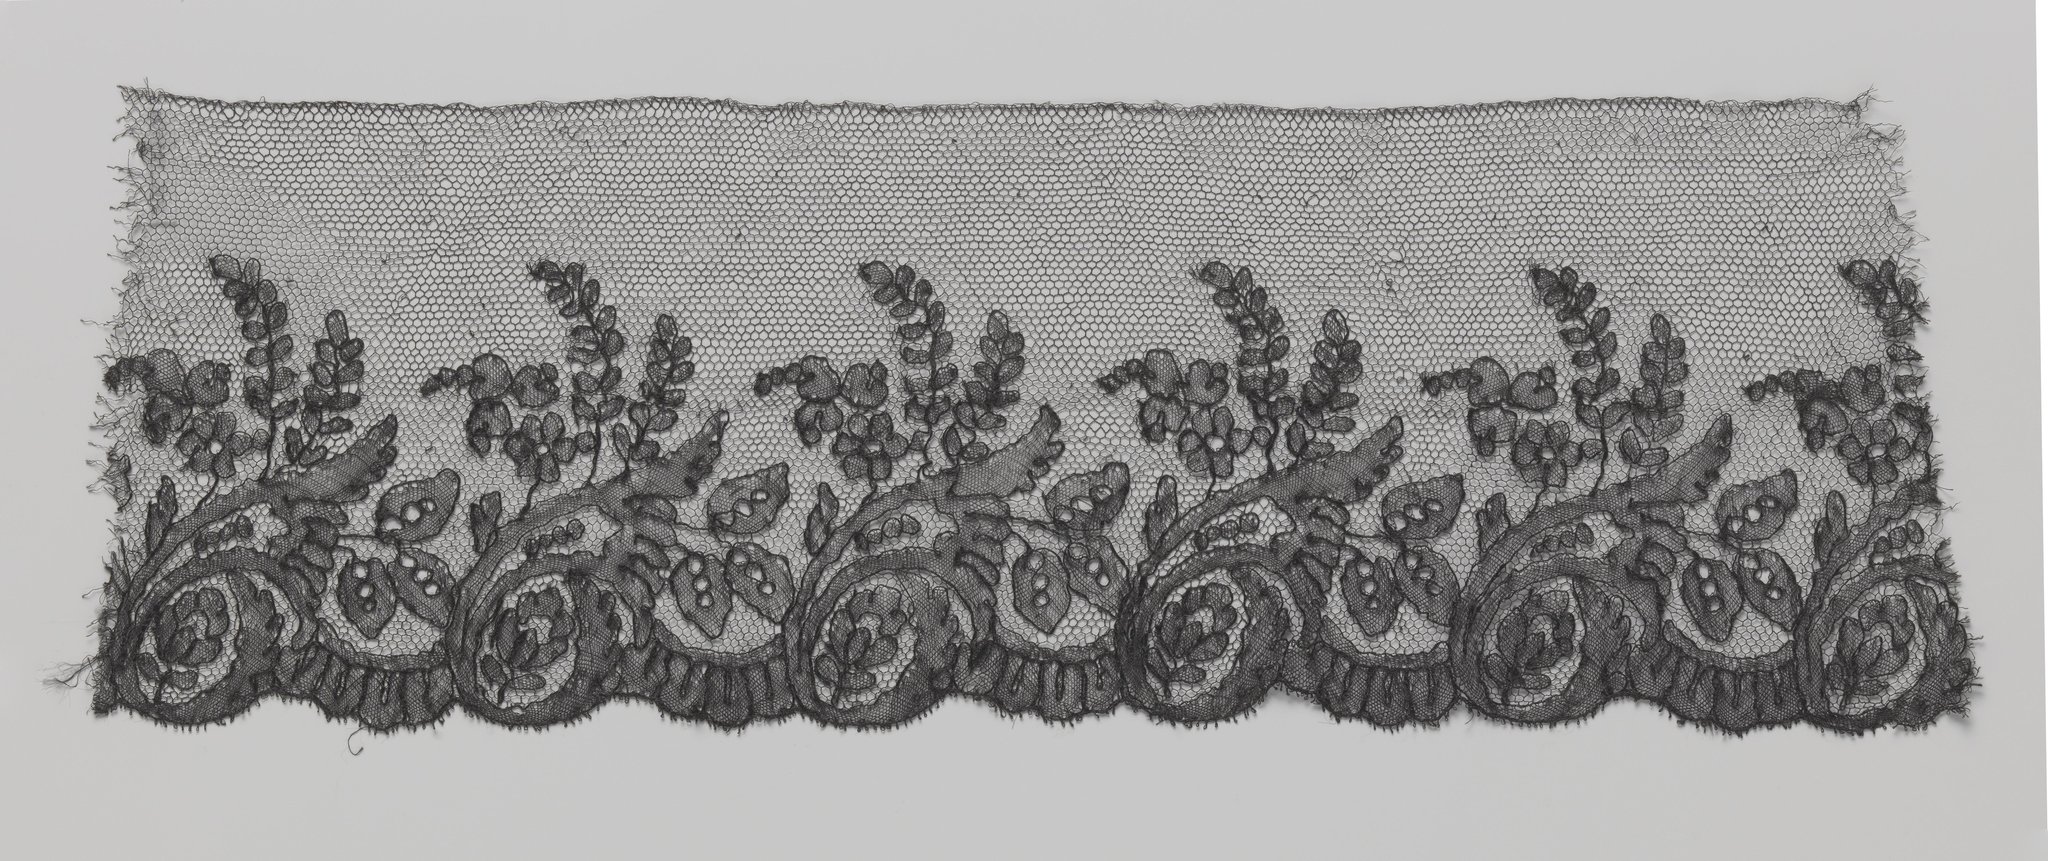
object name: strip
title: Strook zwarte kloskant met omkrullend kelkblad waaruit drie bladeren steken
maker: Anonymous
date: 1890-1910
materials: silk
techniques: lace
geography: belgium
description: Strook zwarte kloskant: Chantilly. Het zich herhalende patroon beslaat tweederde van de strook. Het bestaat langs de onderzijde van de strook uit een omkrullend blad dat eindigt in een naar links gerichte kelkvorm, waaruit drie druppelvormige bladeren steken. In het ovale veld, dat door het omkrullende blad wordt gevormd, staat een takje met blaadjes en een bloem met drie bloemblaadjes. Bovenaan steken enkele bladertakken en een rozetbloempje uit de zijkant van de kelk omhoog. De schulpenrand langs de onderzijde van de strook wordt gevormd door de opeenvolgende omkrullende bladeren, die met elkaar worden verbonden door vier aaneengeschakelde u-vormige motiefjes. De motieven zijn gemaakt in netslag en voorzien van contourdraden. De motieven zijn met elkaar verbonden door een zeshoekige traliegrond, een tulegrond. De bovenzijde van de strook is recht afgewerkt. De schulpenrand is afgewerkt met picots.